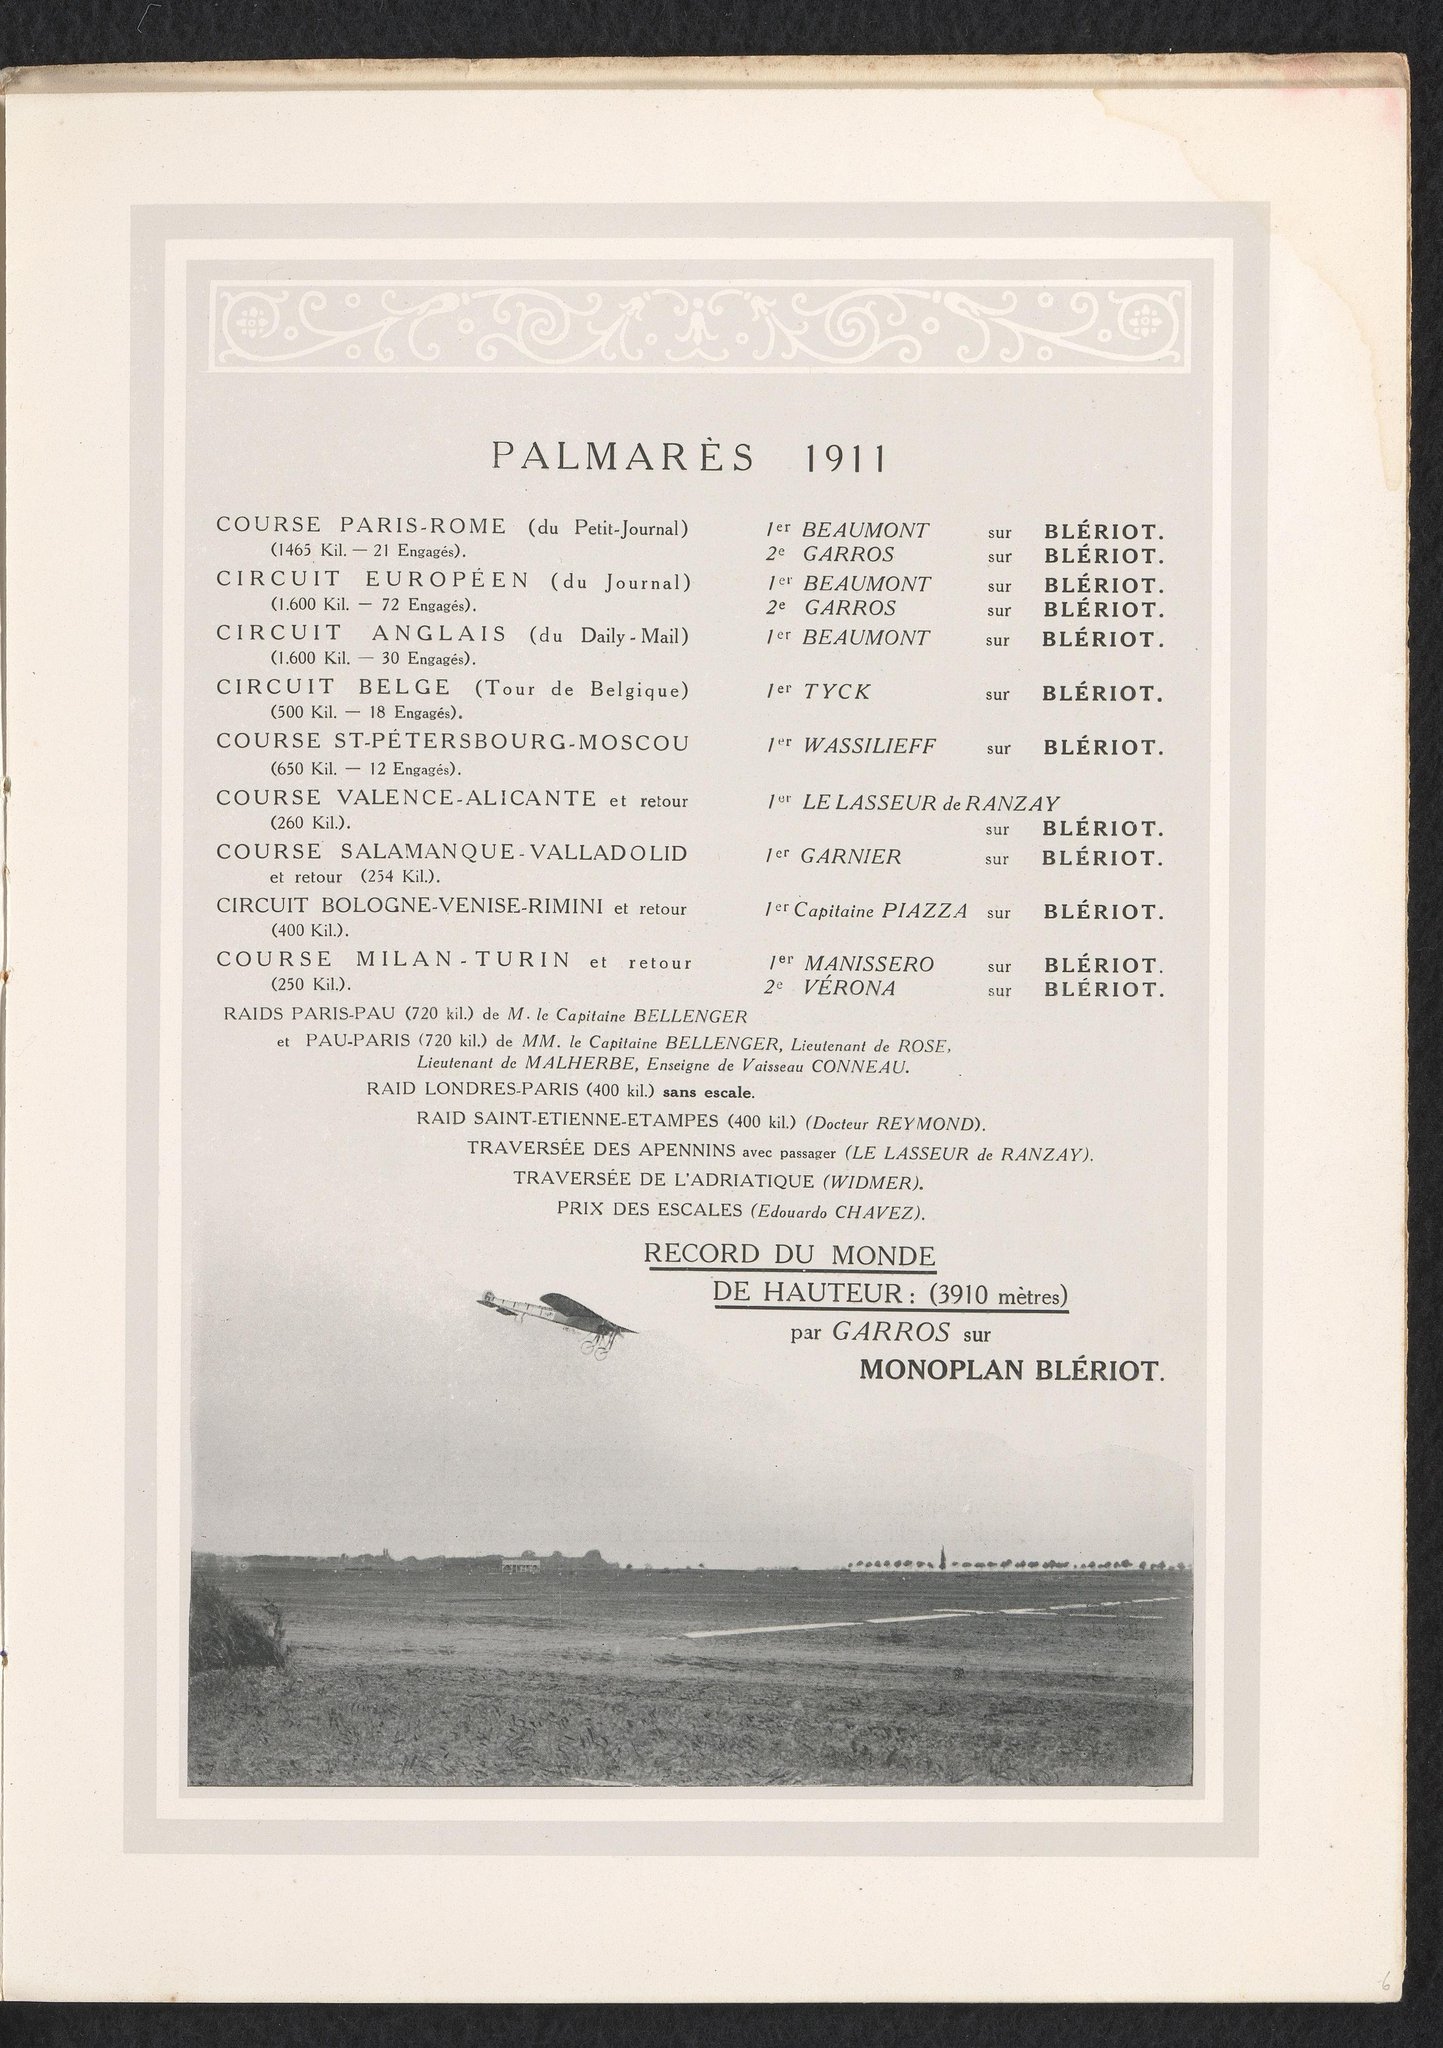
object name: page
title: Vliegtuig boven open veld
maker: Anonymous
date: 1907-1912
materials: paper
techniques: autotype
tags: aircraft, aeroplane, plain